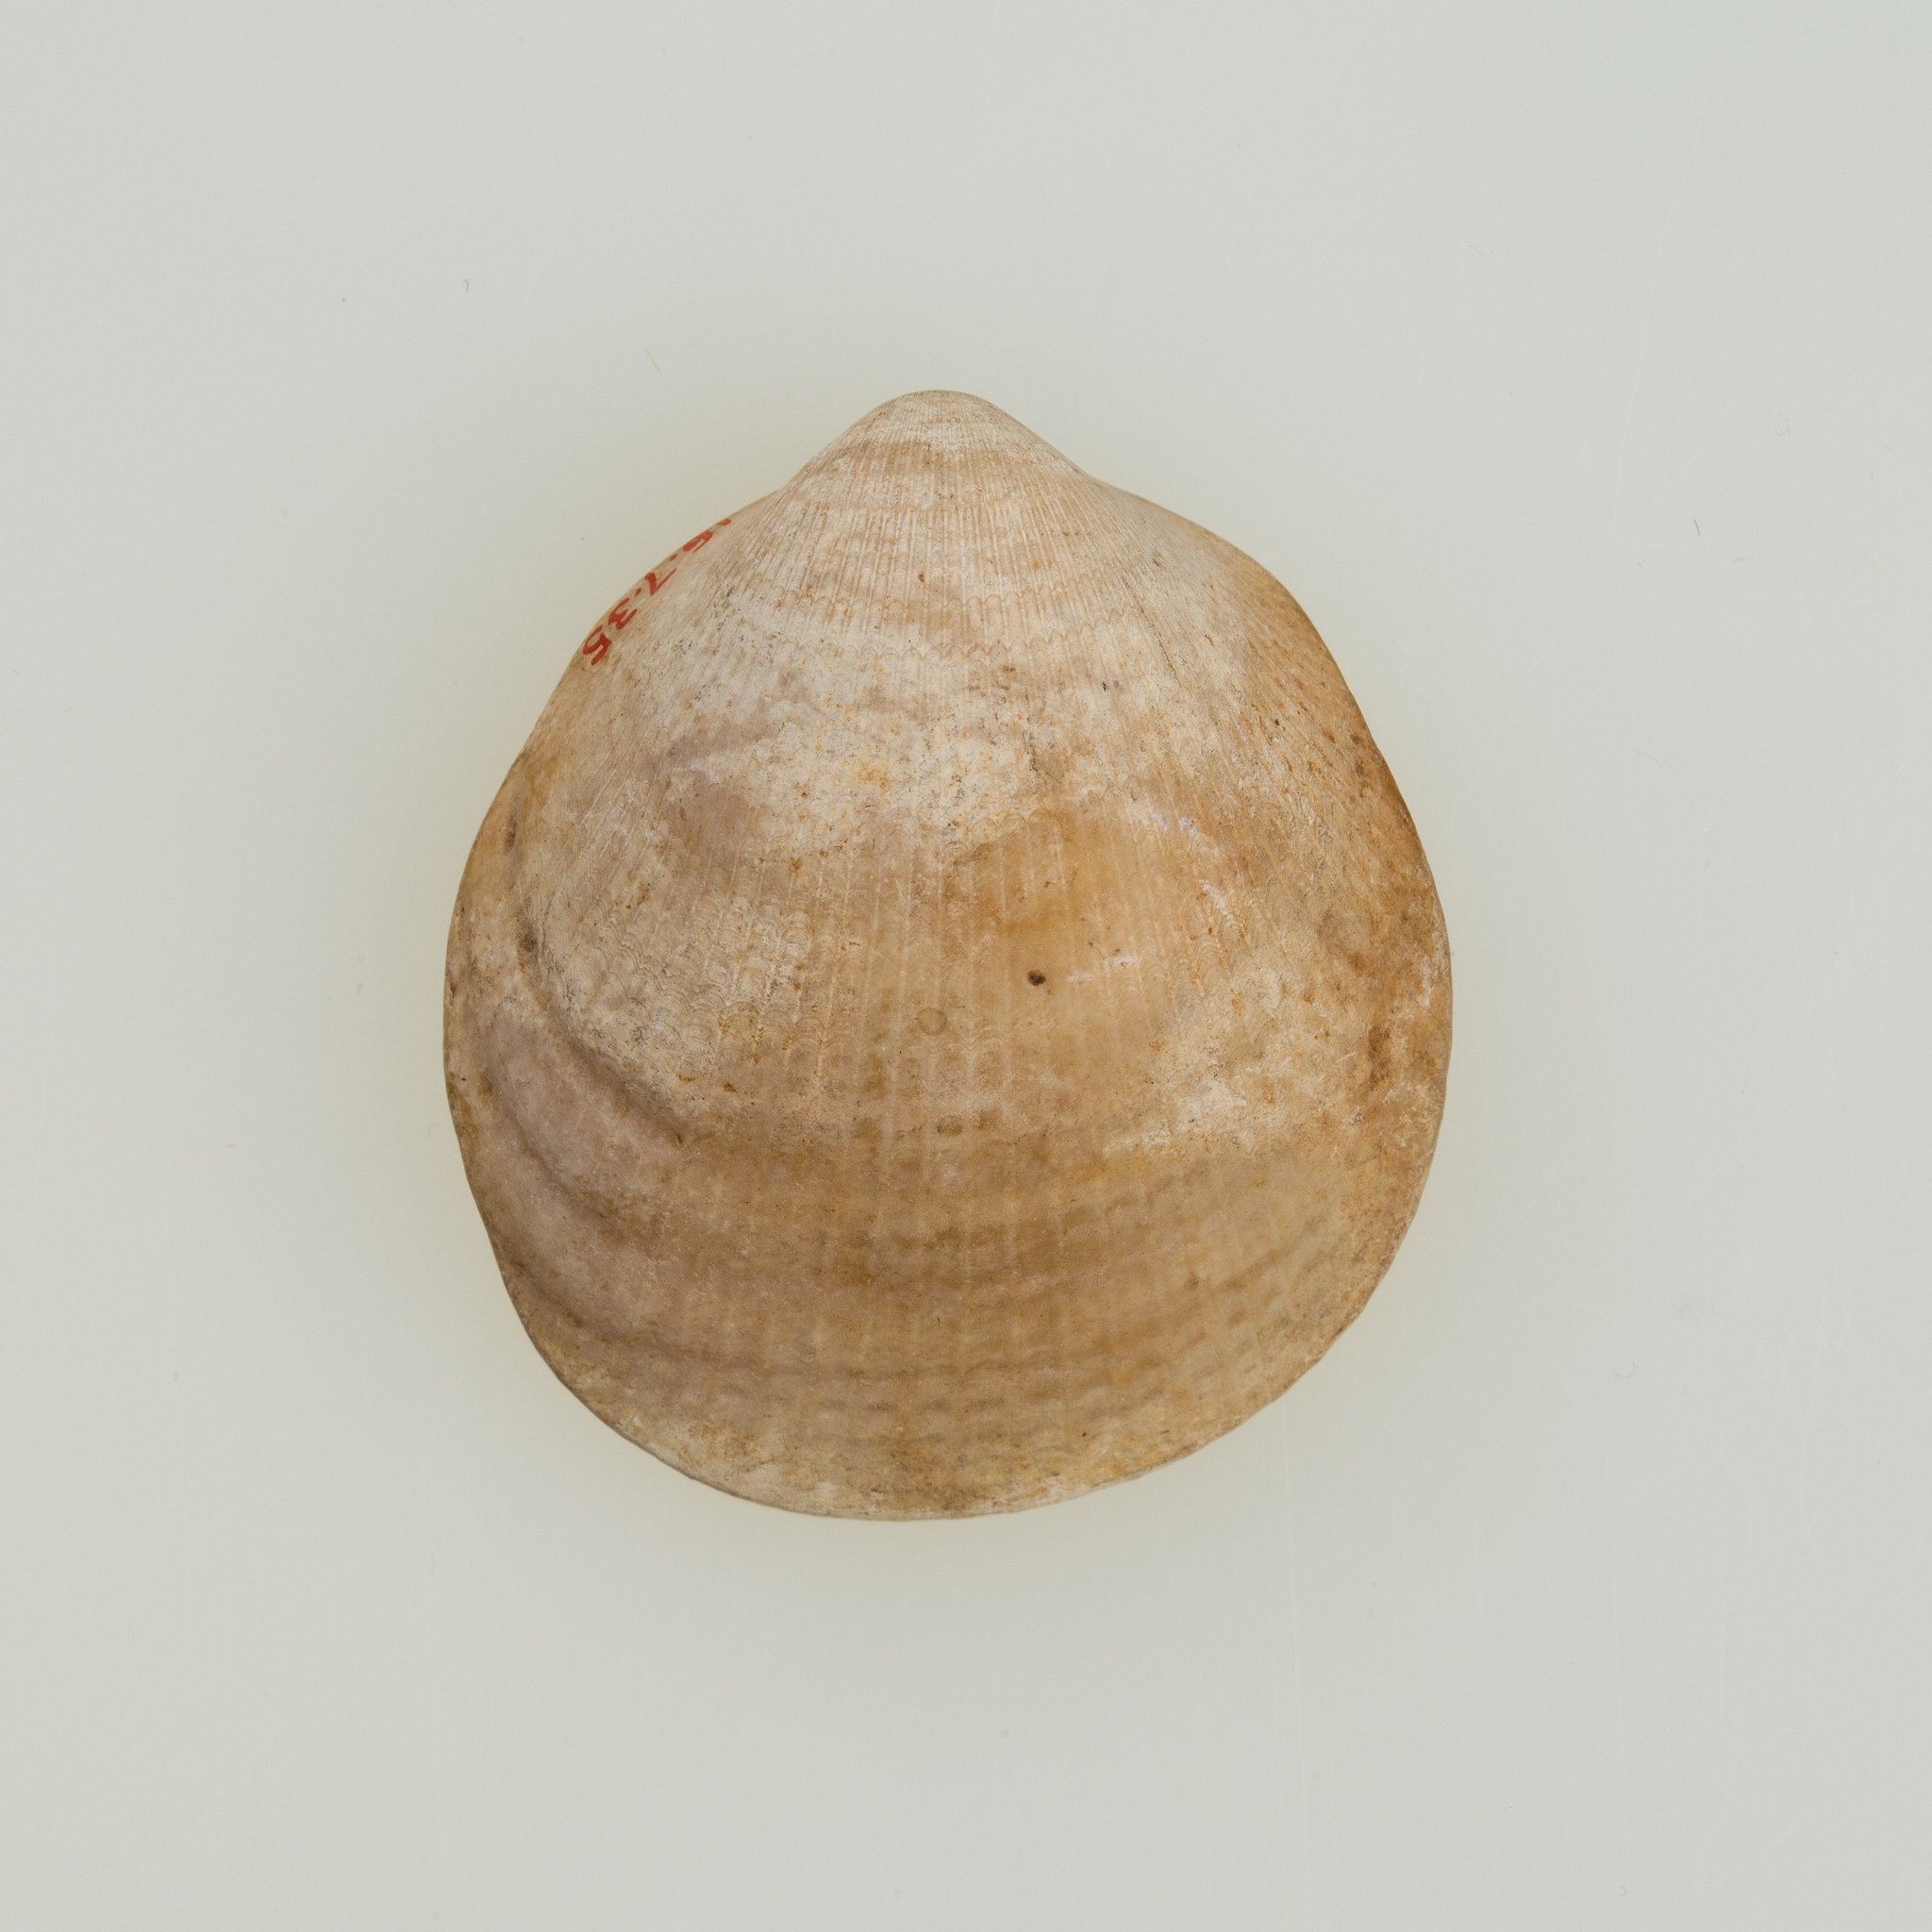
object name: pendant, shell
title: Shell pendant or bead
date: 3850-2960 BCE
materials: shell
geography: egypt